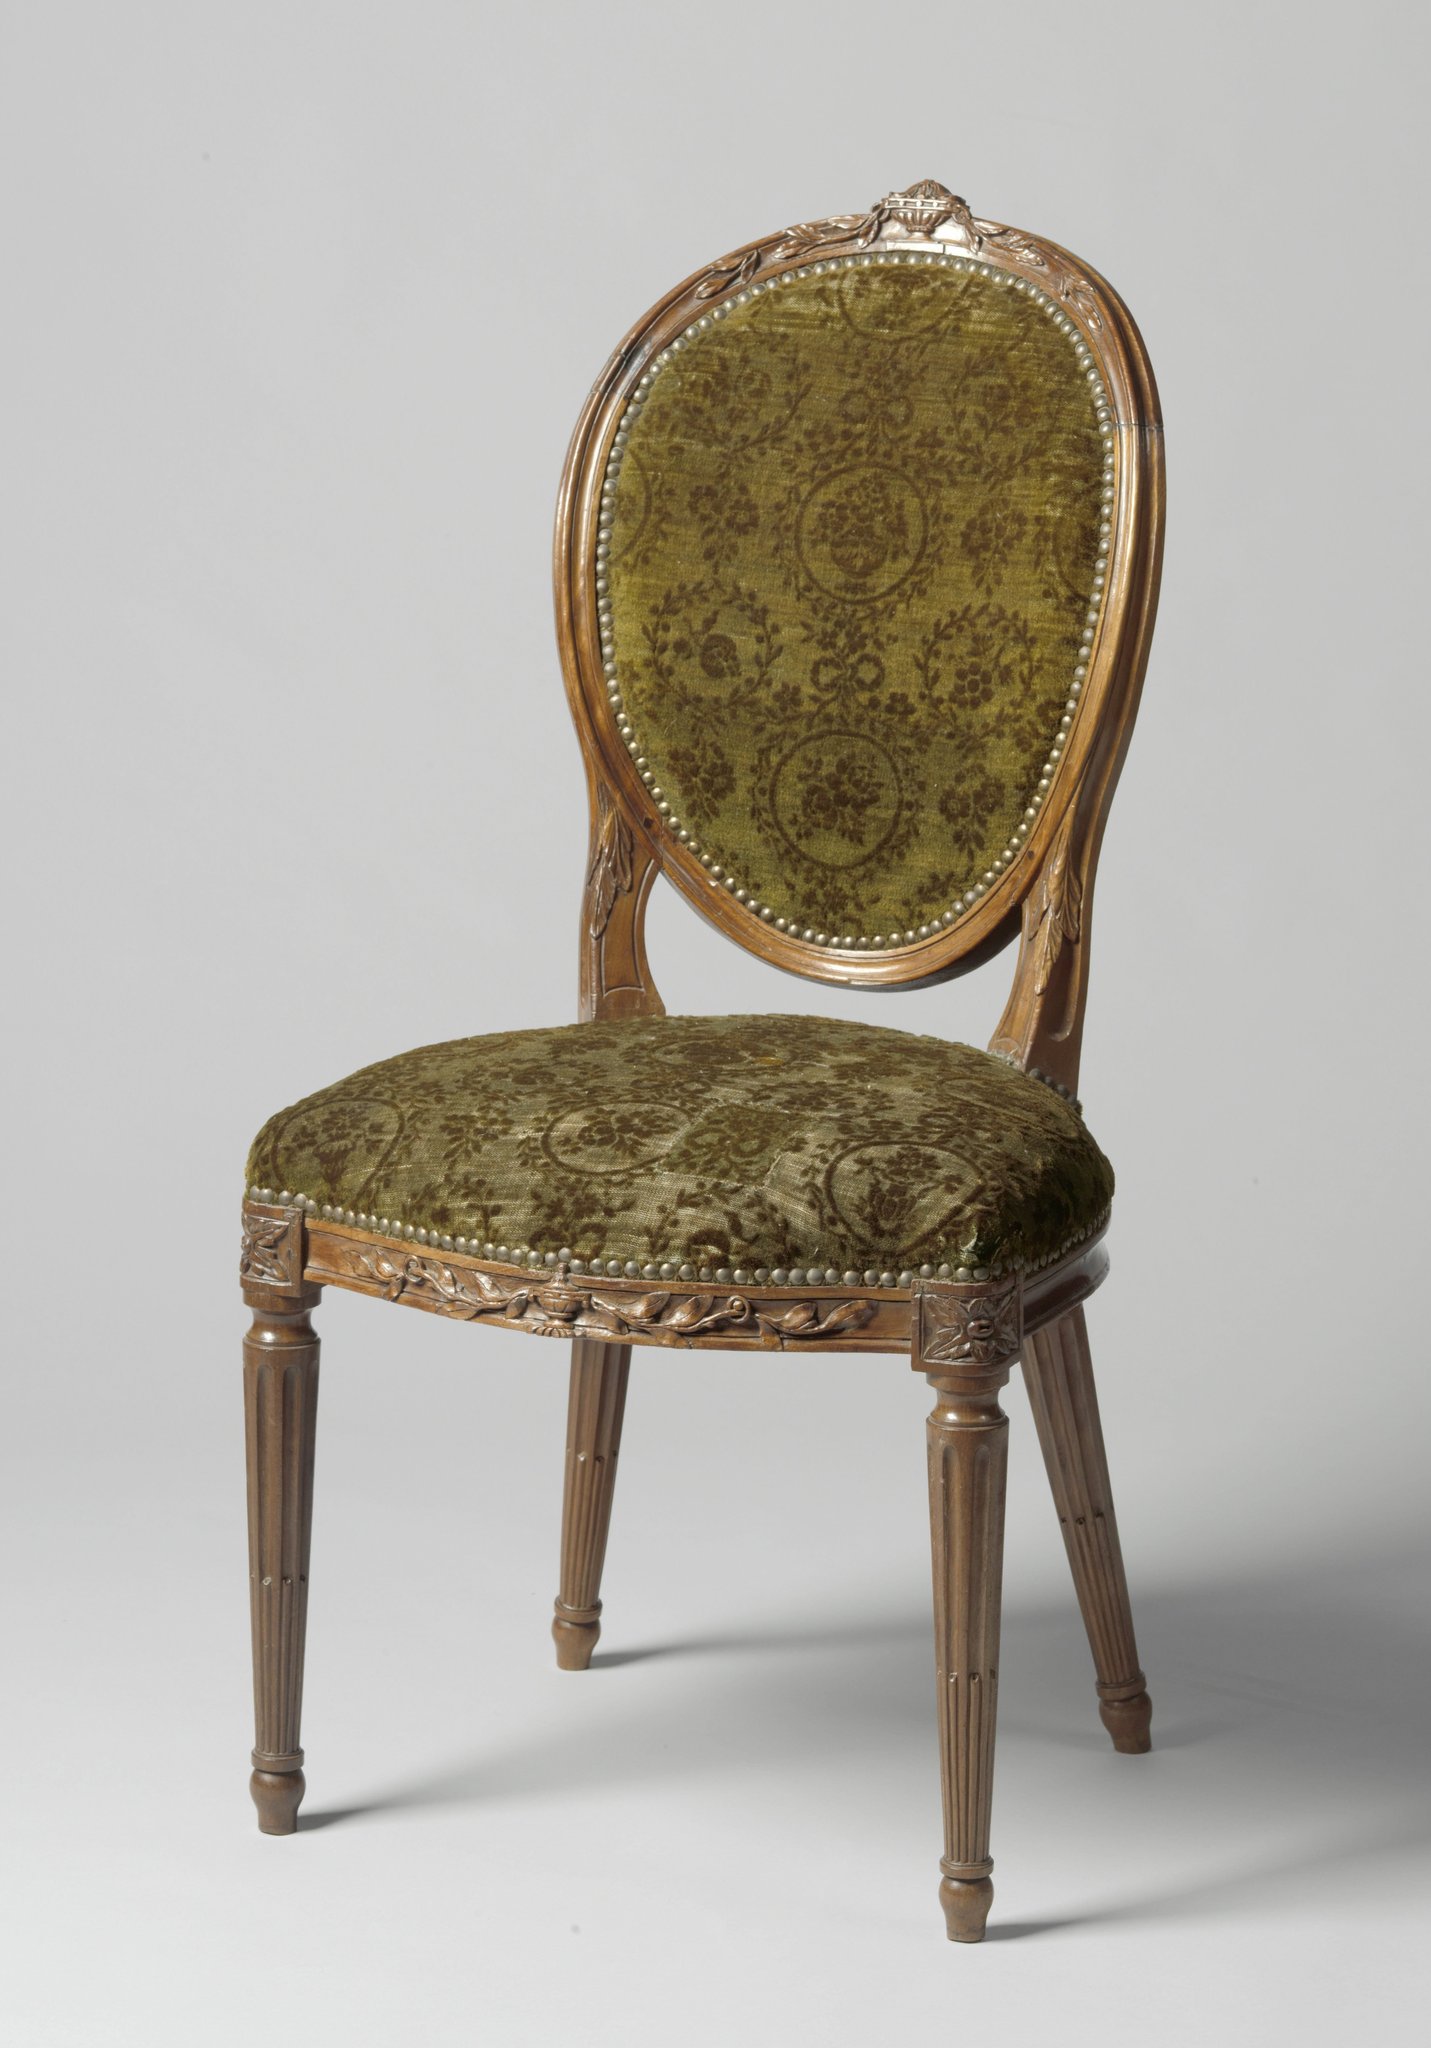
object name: chair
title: Stoel van mahoniehout, bekleed met groene trijp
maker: Anonymous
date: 1775-1800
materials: wood, textile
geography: northern netherlands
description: Armchair. Mahogany, the velvet upholstery has been renewed. Netherlands, c. 1780 - 1800. Given by Mr and Mrs Drucker-Fraser, 1922.